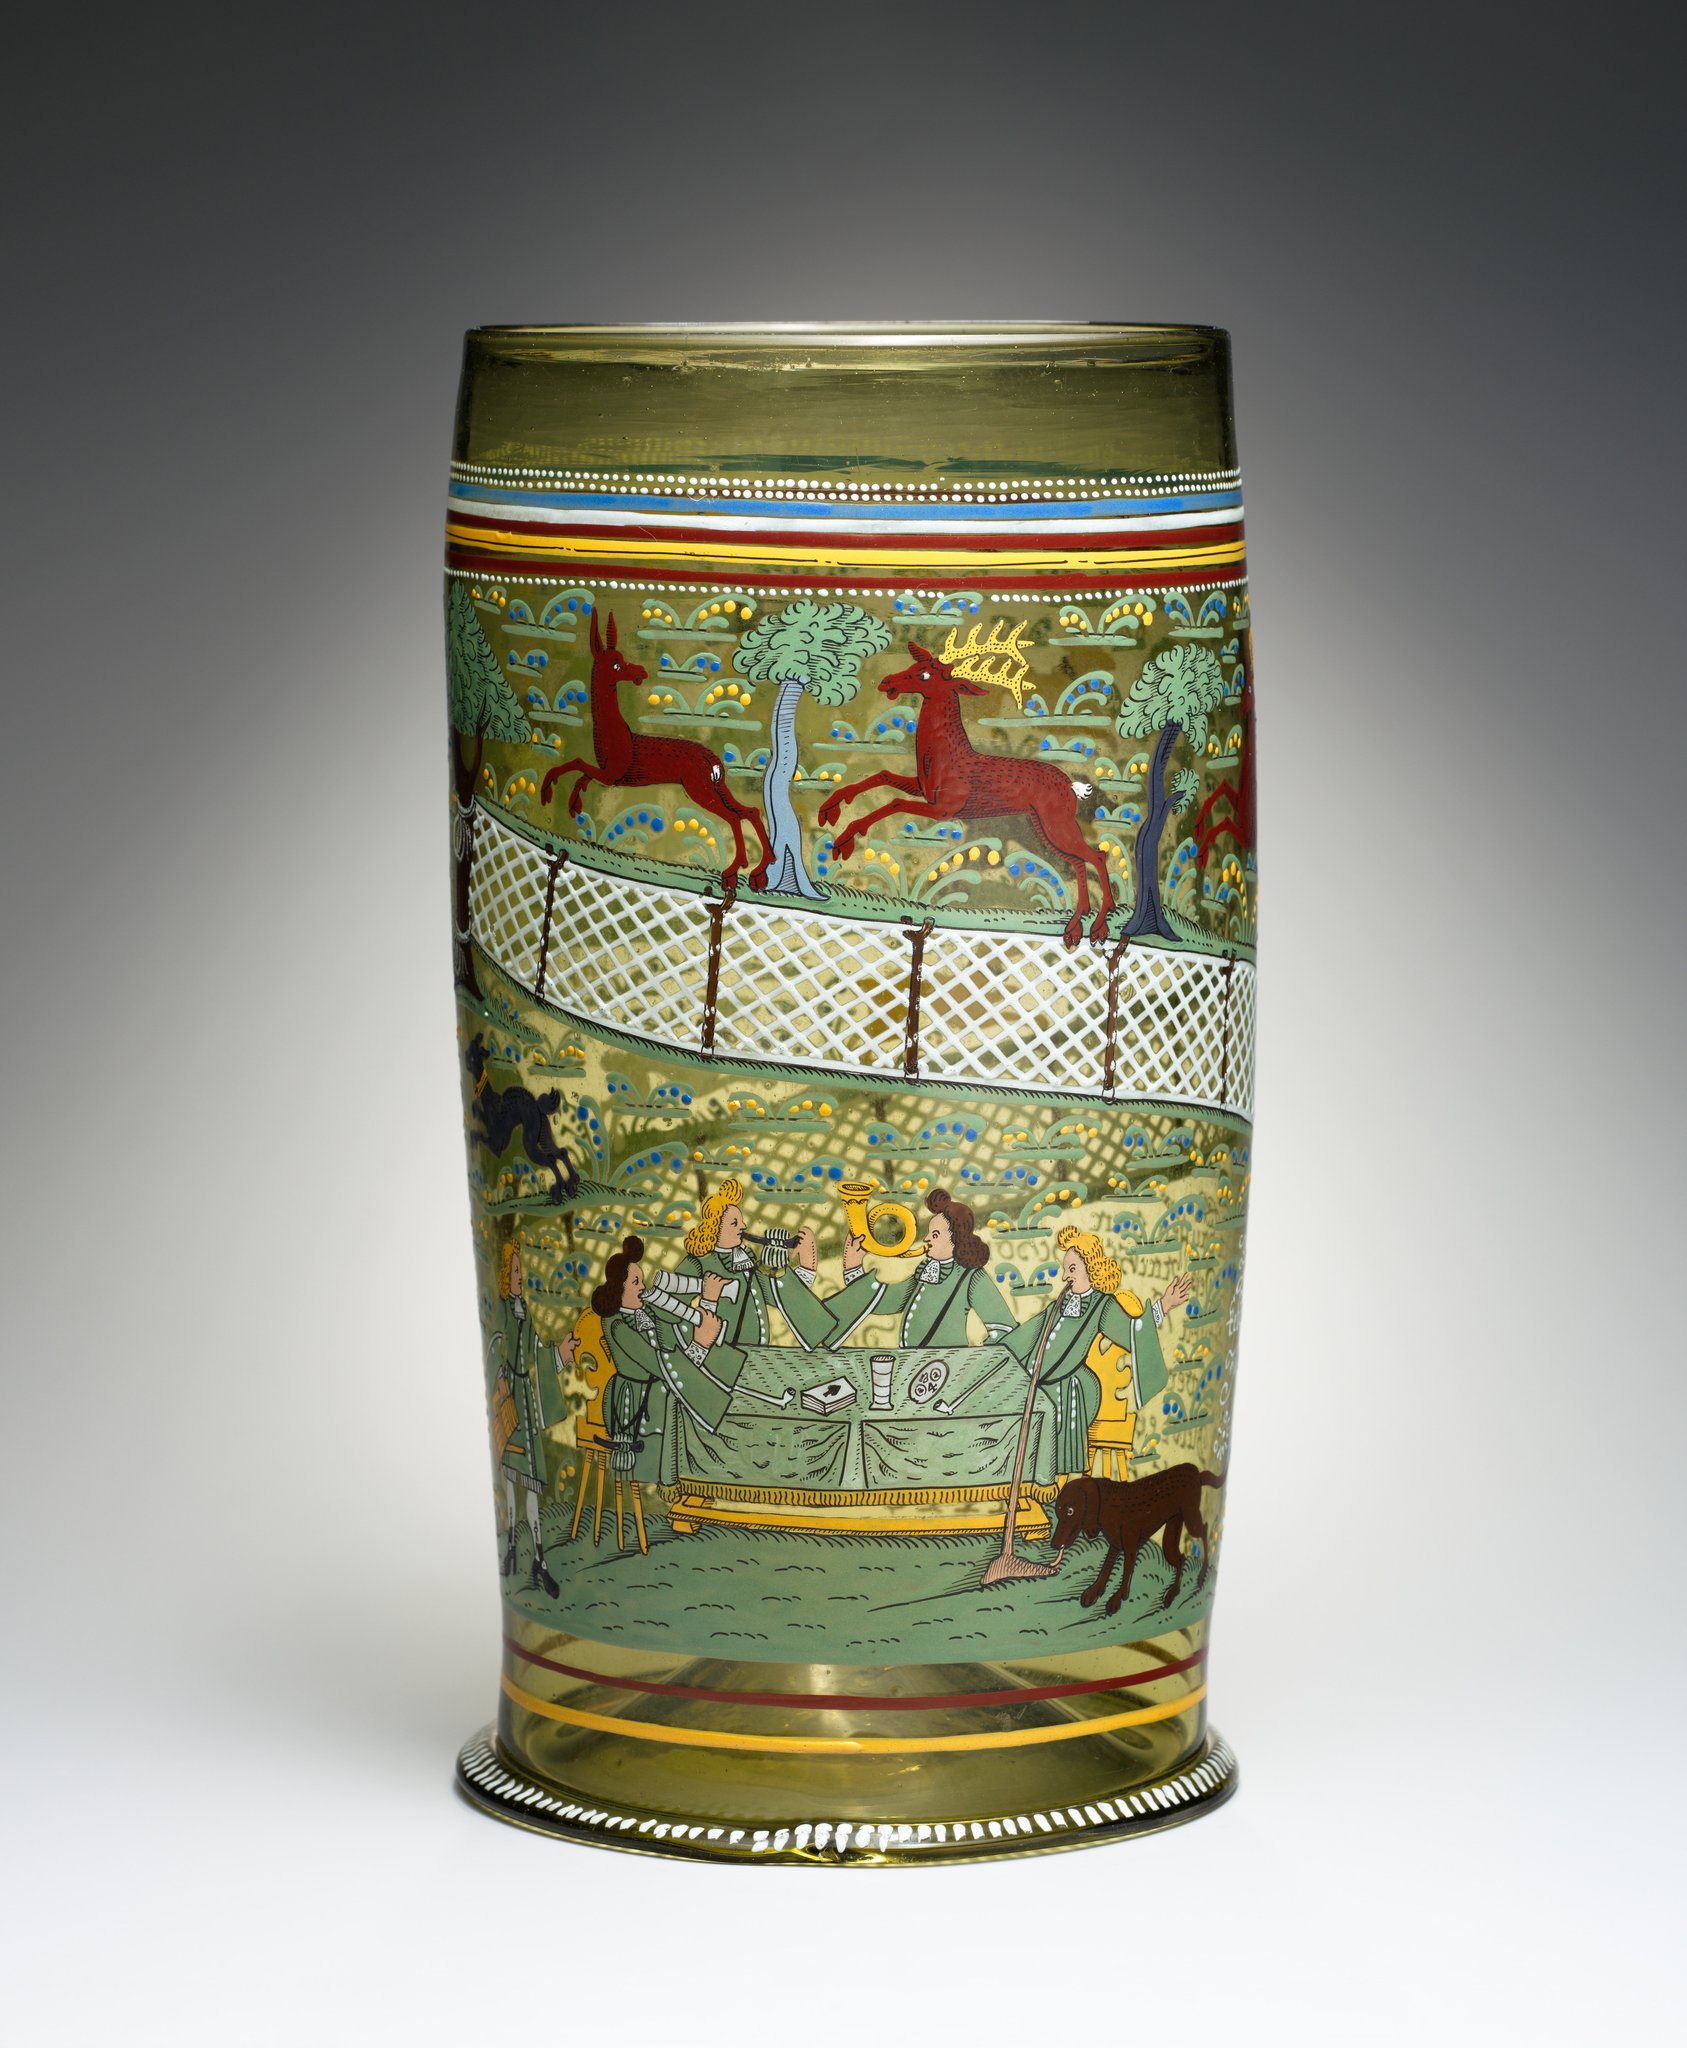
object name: beaker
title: Beaker (Humpen)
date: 1692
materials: glass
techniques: enamel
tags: men,deer,dogs,drinking